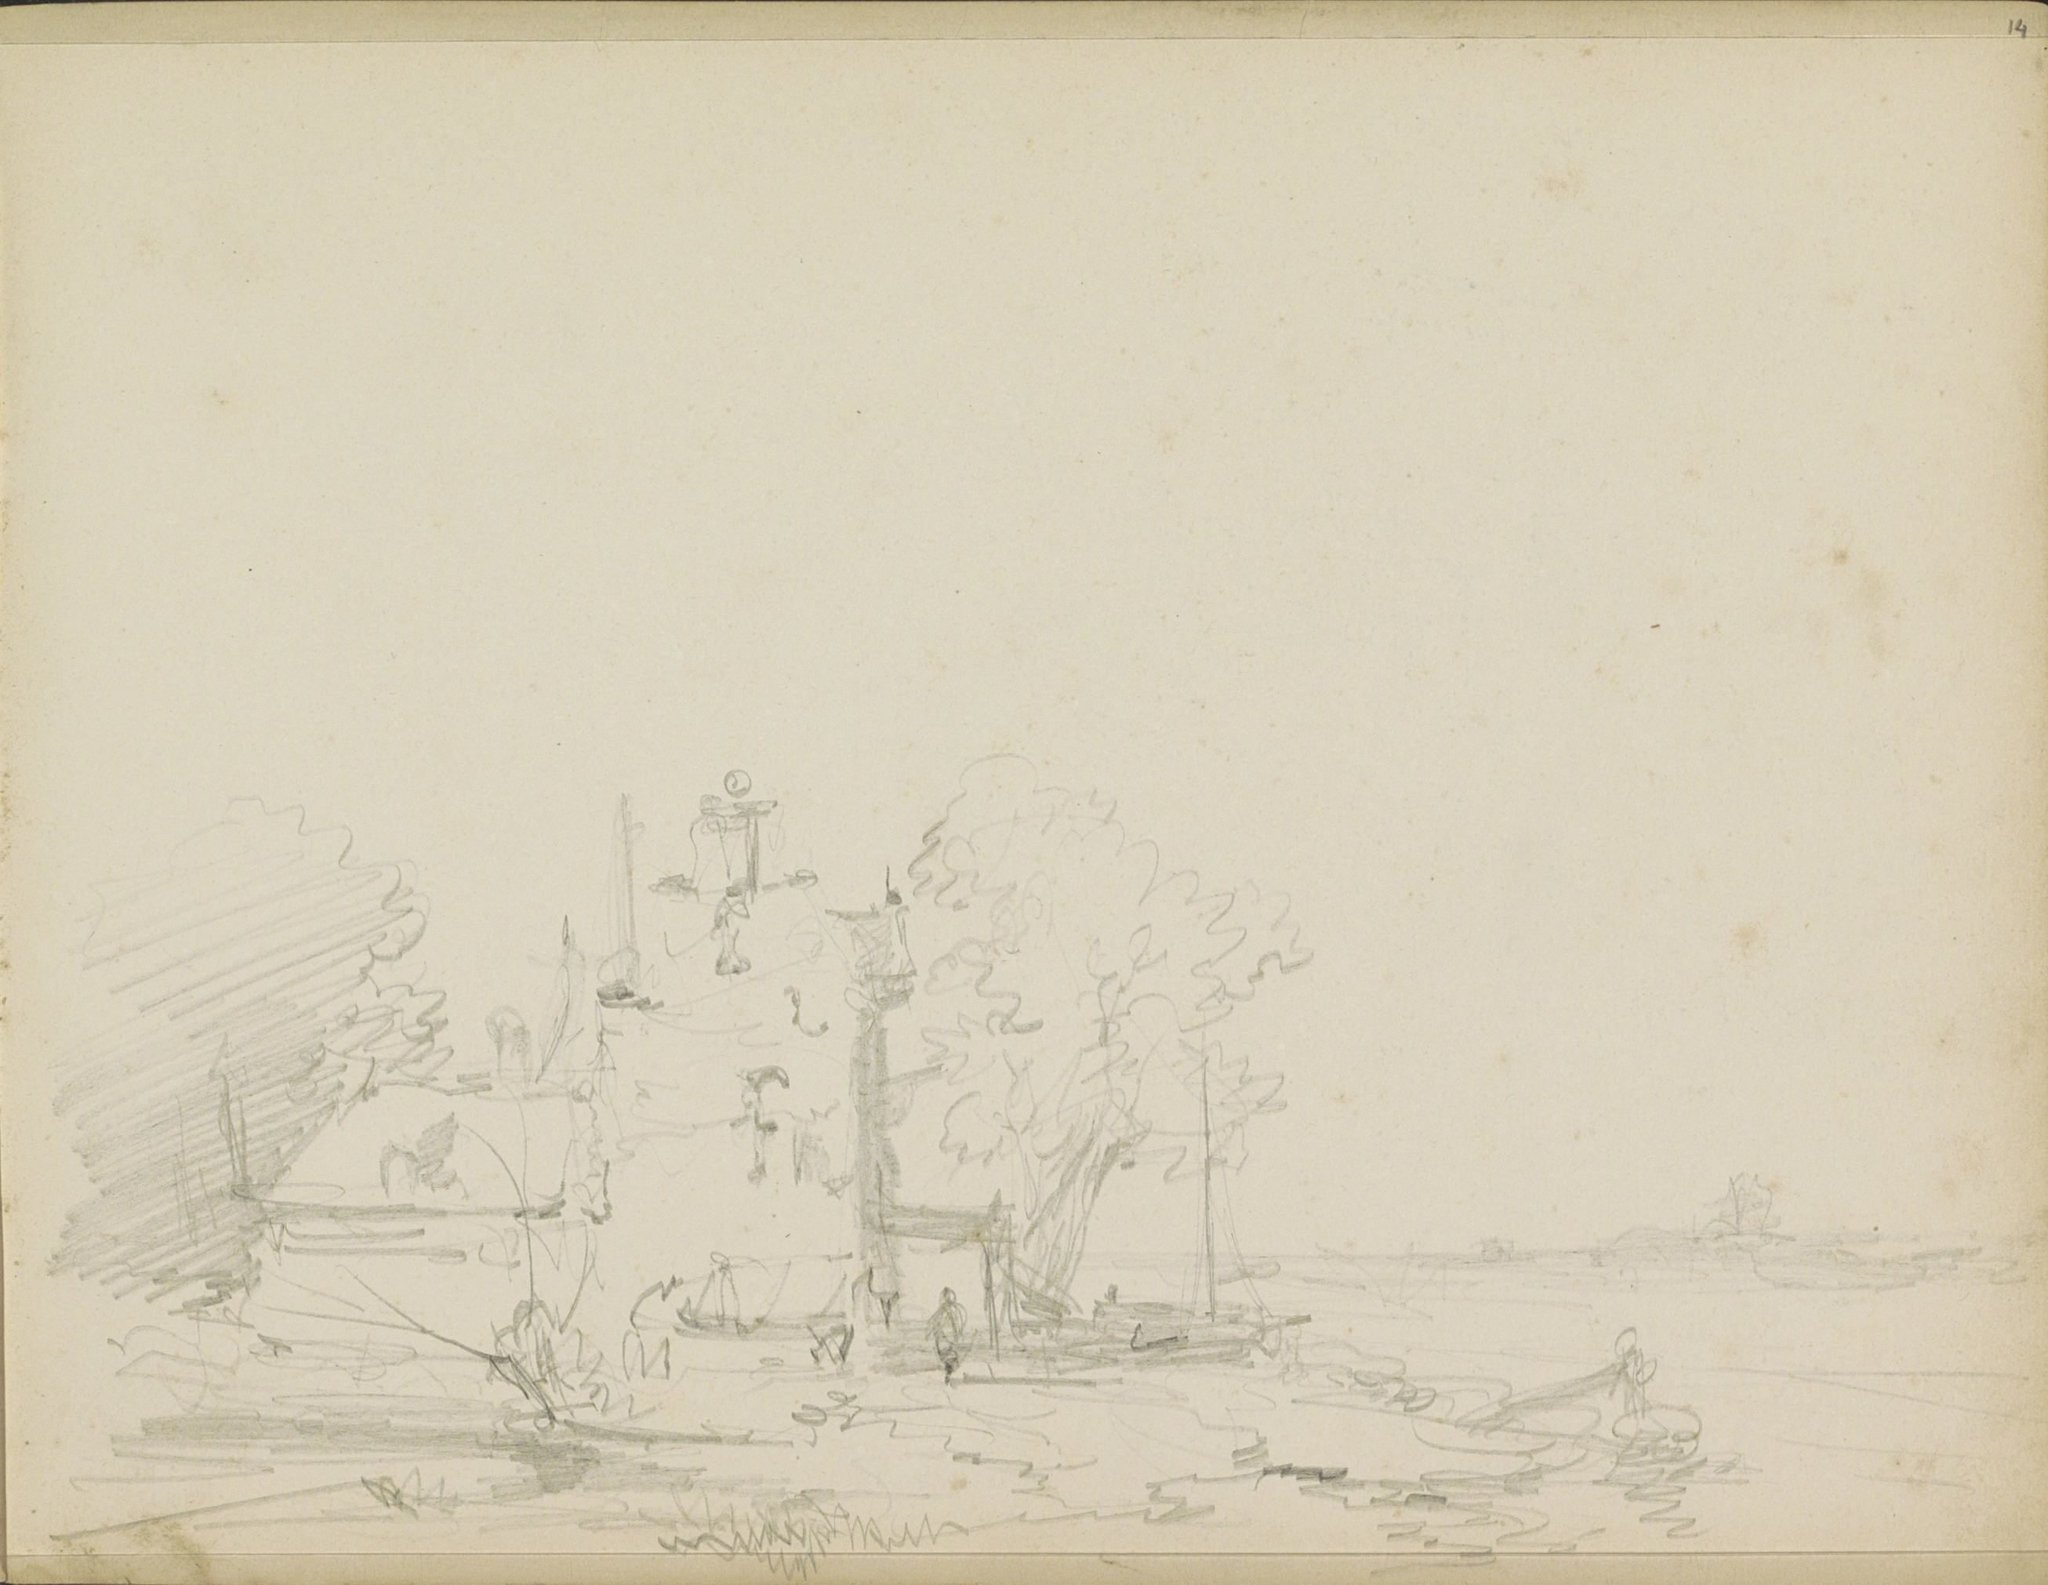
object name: sketchbook leaf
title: Gezicht op een gebouw aan het water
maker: adrianus eversen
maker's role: draughtsman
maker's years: 1818-1897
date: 1828-1897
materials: paper, pencil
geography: netherlands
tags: sailing-ship, sailing-boat, rural housing, e.g. country-house, villa, cottage, landscapes with waters, waterscapes, seascapes (in the temperate zone) (+ landscape with figures, staffage)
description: Gezicht op een gebouw aan het water. Voor het gebouw een figuur. Rechts van de figuur ligt een zeilschip aangemeerd. Blad 14 recto uit een schetsboek met 41 bladen.